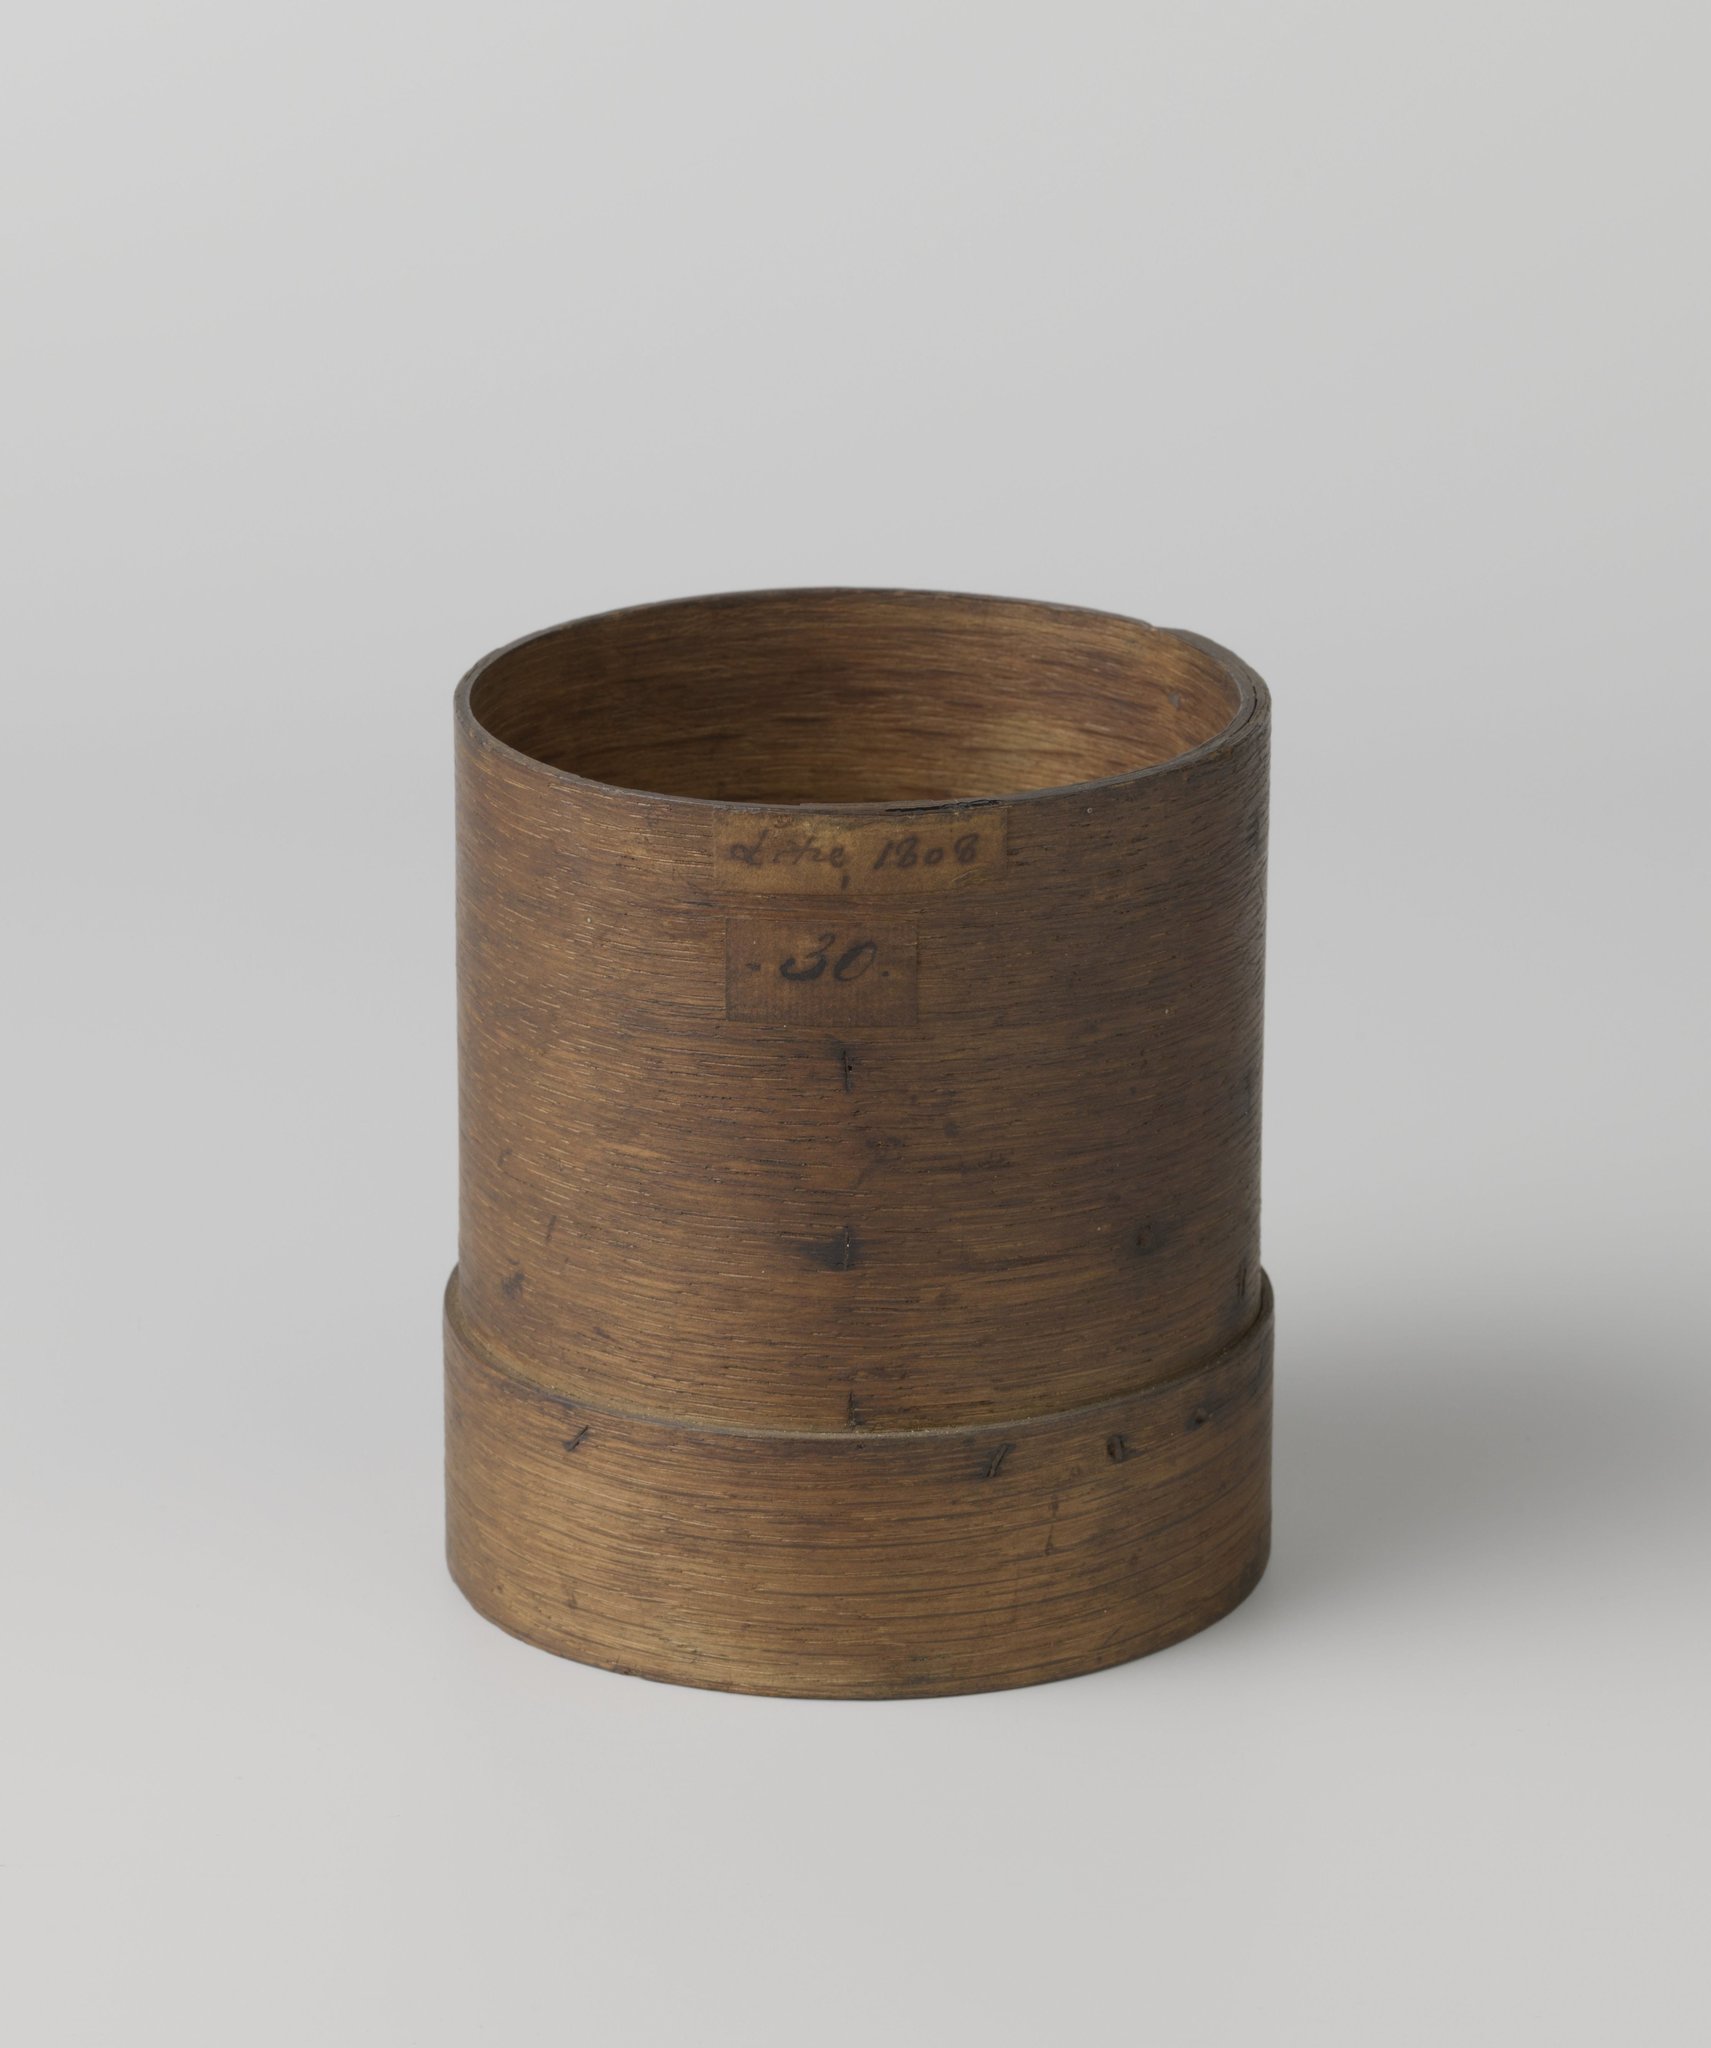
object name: inhoudsmaat droge waren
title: Inhoudsmaat van 1 liter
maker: Anonymous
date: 1825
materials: wood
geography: netherlands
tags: netherlands